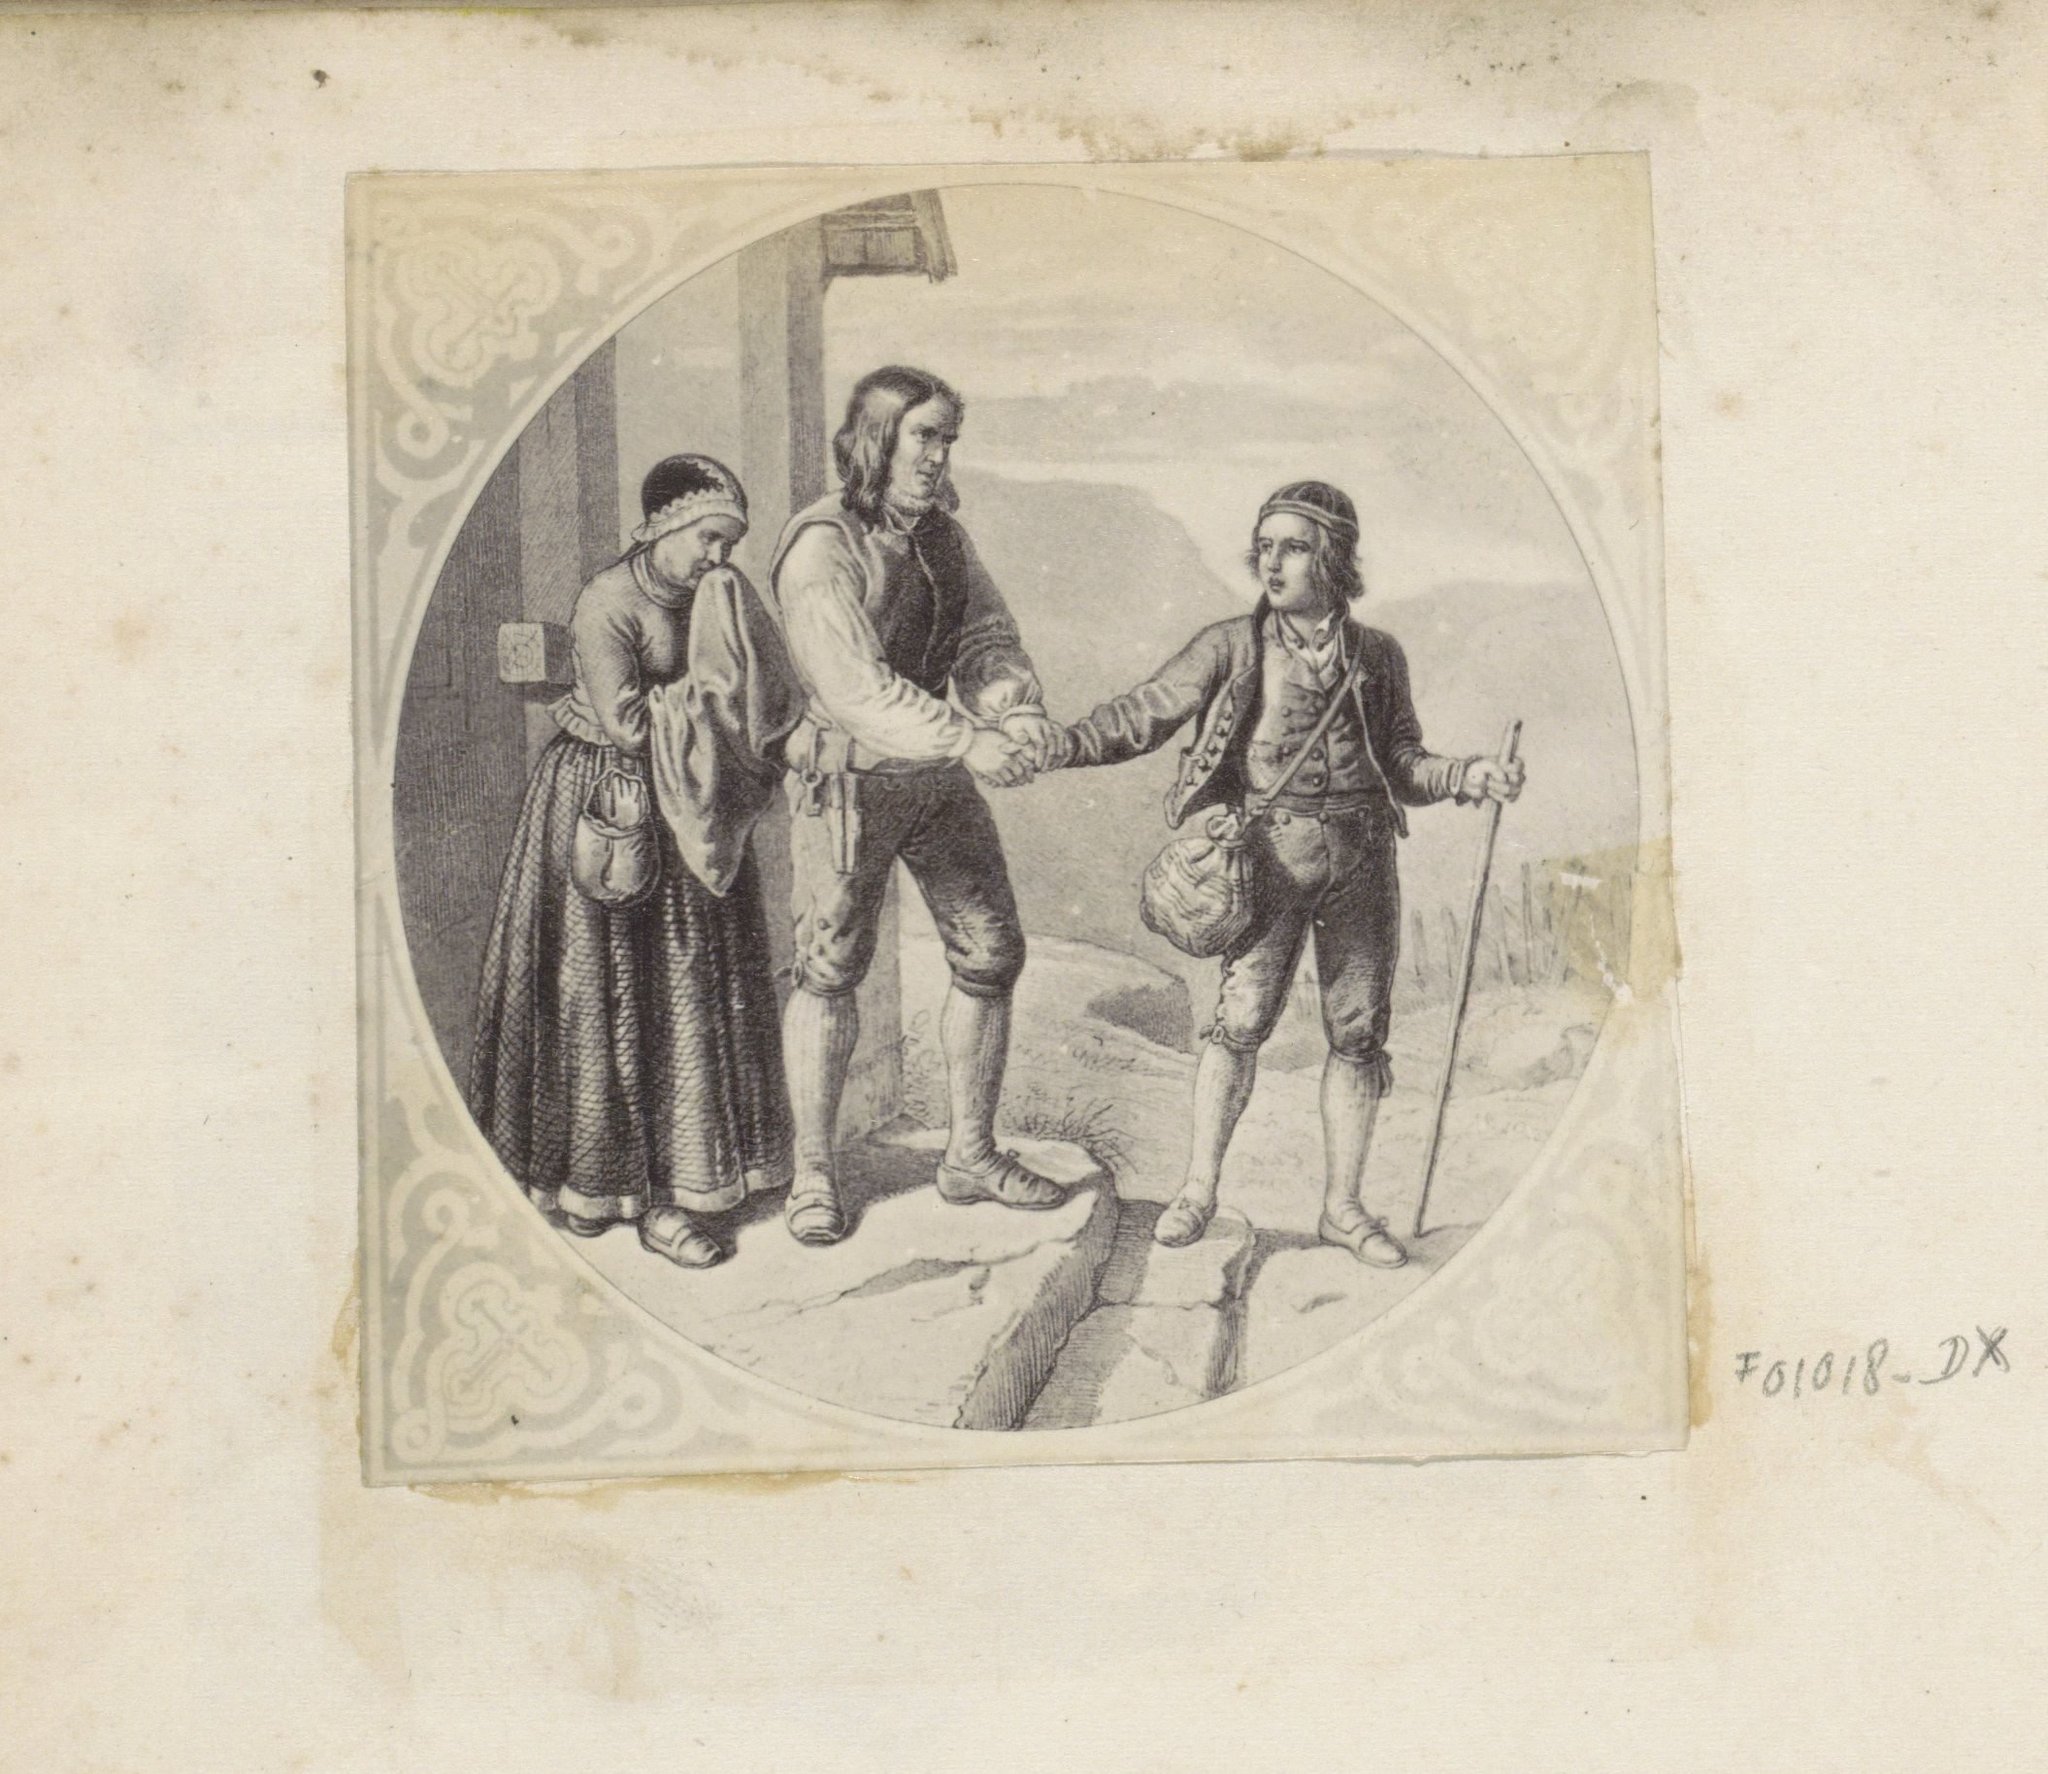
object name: reproduction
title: Fotoreproductie van (vermoedelijk) een prent naar een schilderij van Adolph Tidemand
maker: Anonymous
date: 1860-1870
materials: paper, photographic support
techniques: albumen print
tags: bag, walking-stick, staff, weeping, child (young man, young woman) leaving his (her) parents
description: Onderdeel van Engels familiealbum met foto's van personen, reizen, cricket en kunstwerken.